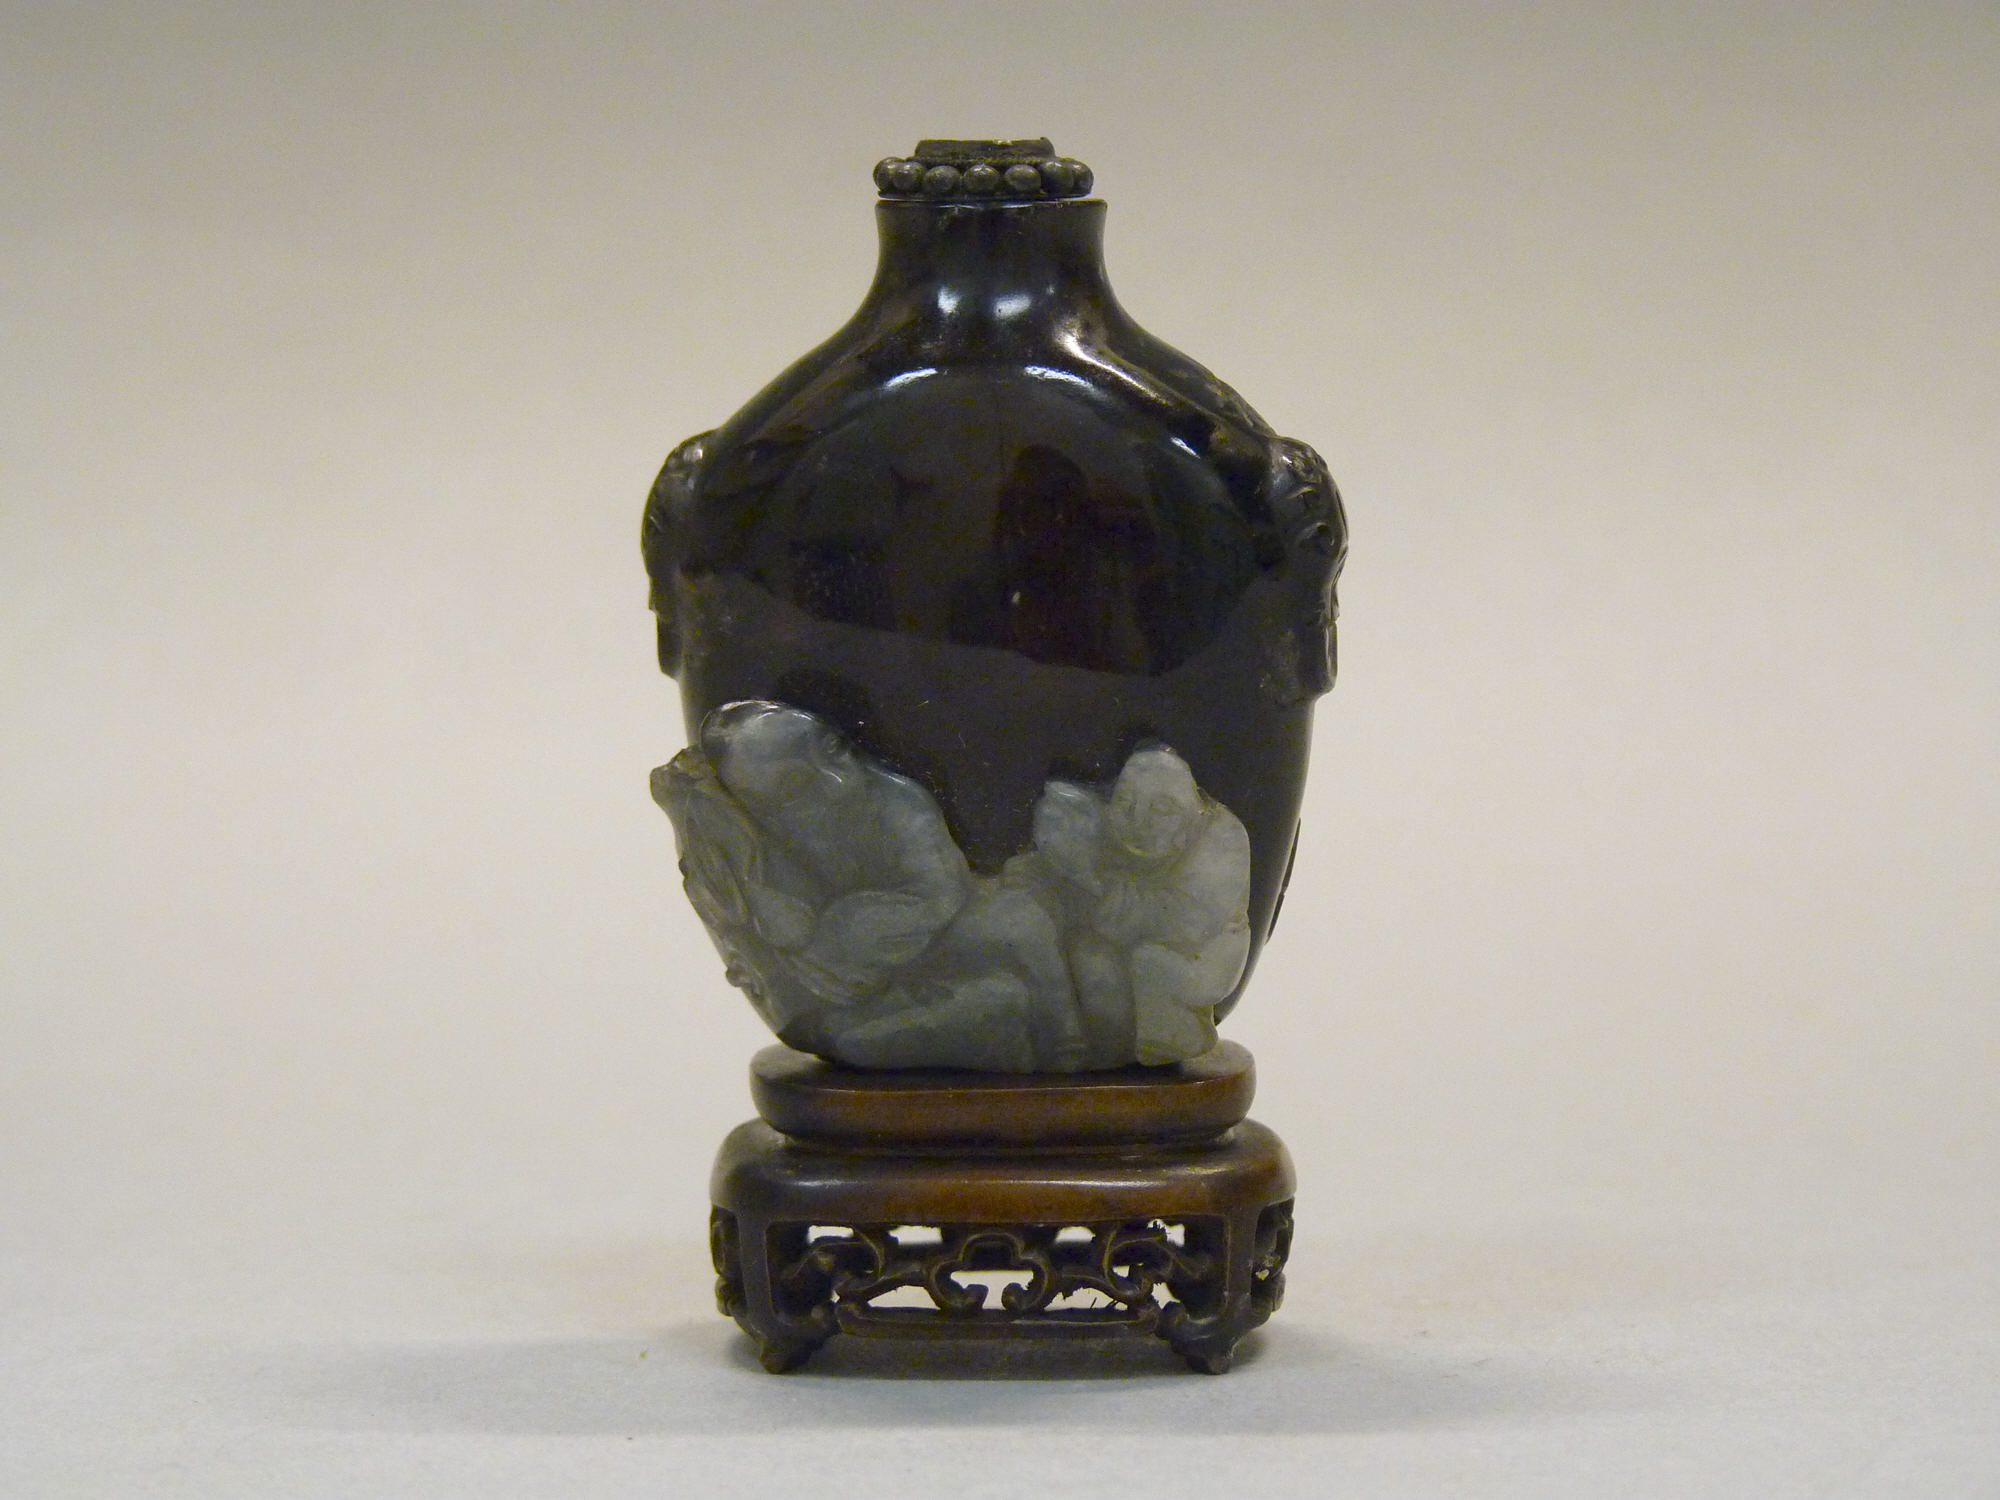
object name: snuff bottle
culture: chinese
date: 1736-1795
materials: jade, quartz, silver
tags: men